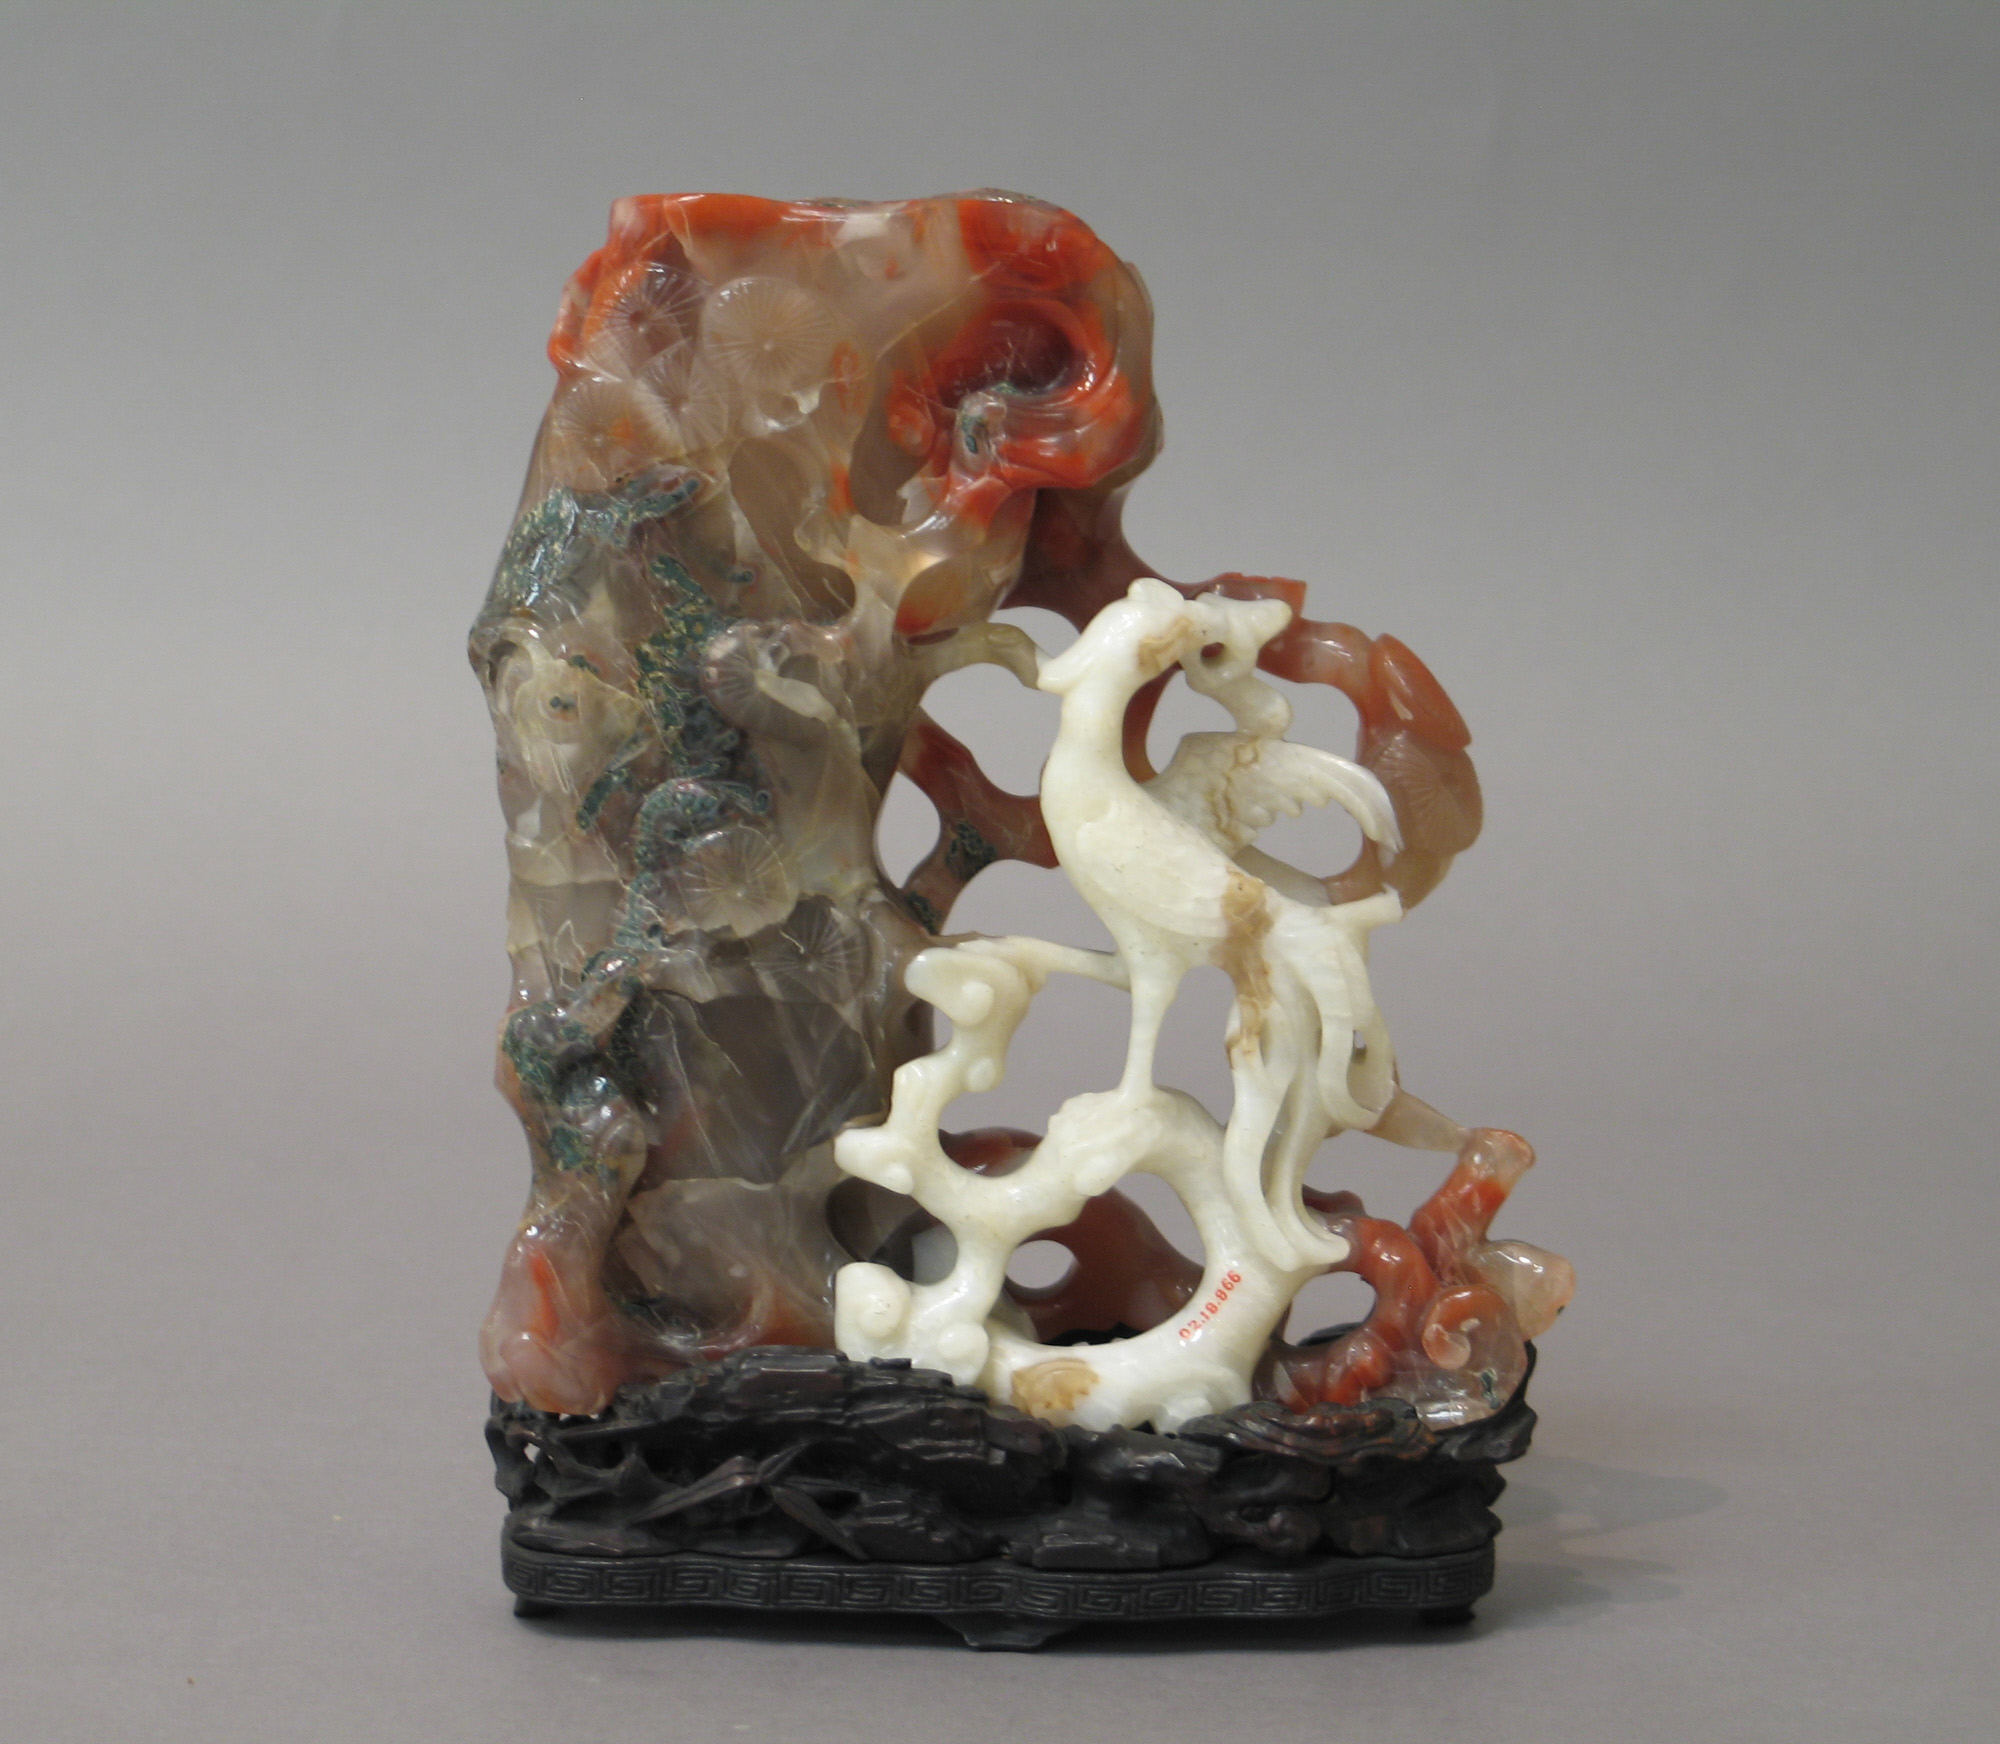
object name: vase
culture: chinese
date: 1701-1800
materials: stone, gemstone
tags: phoenix